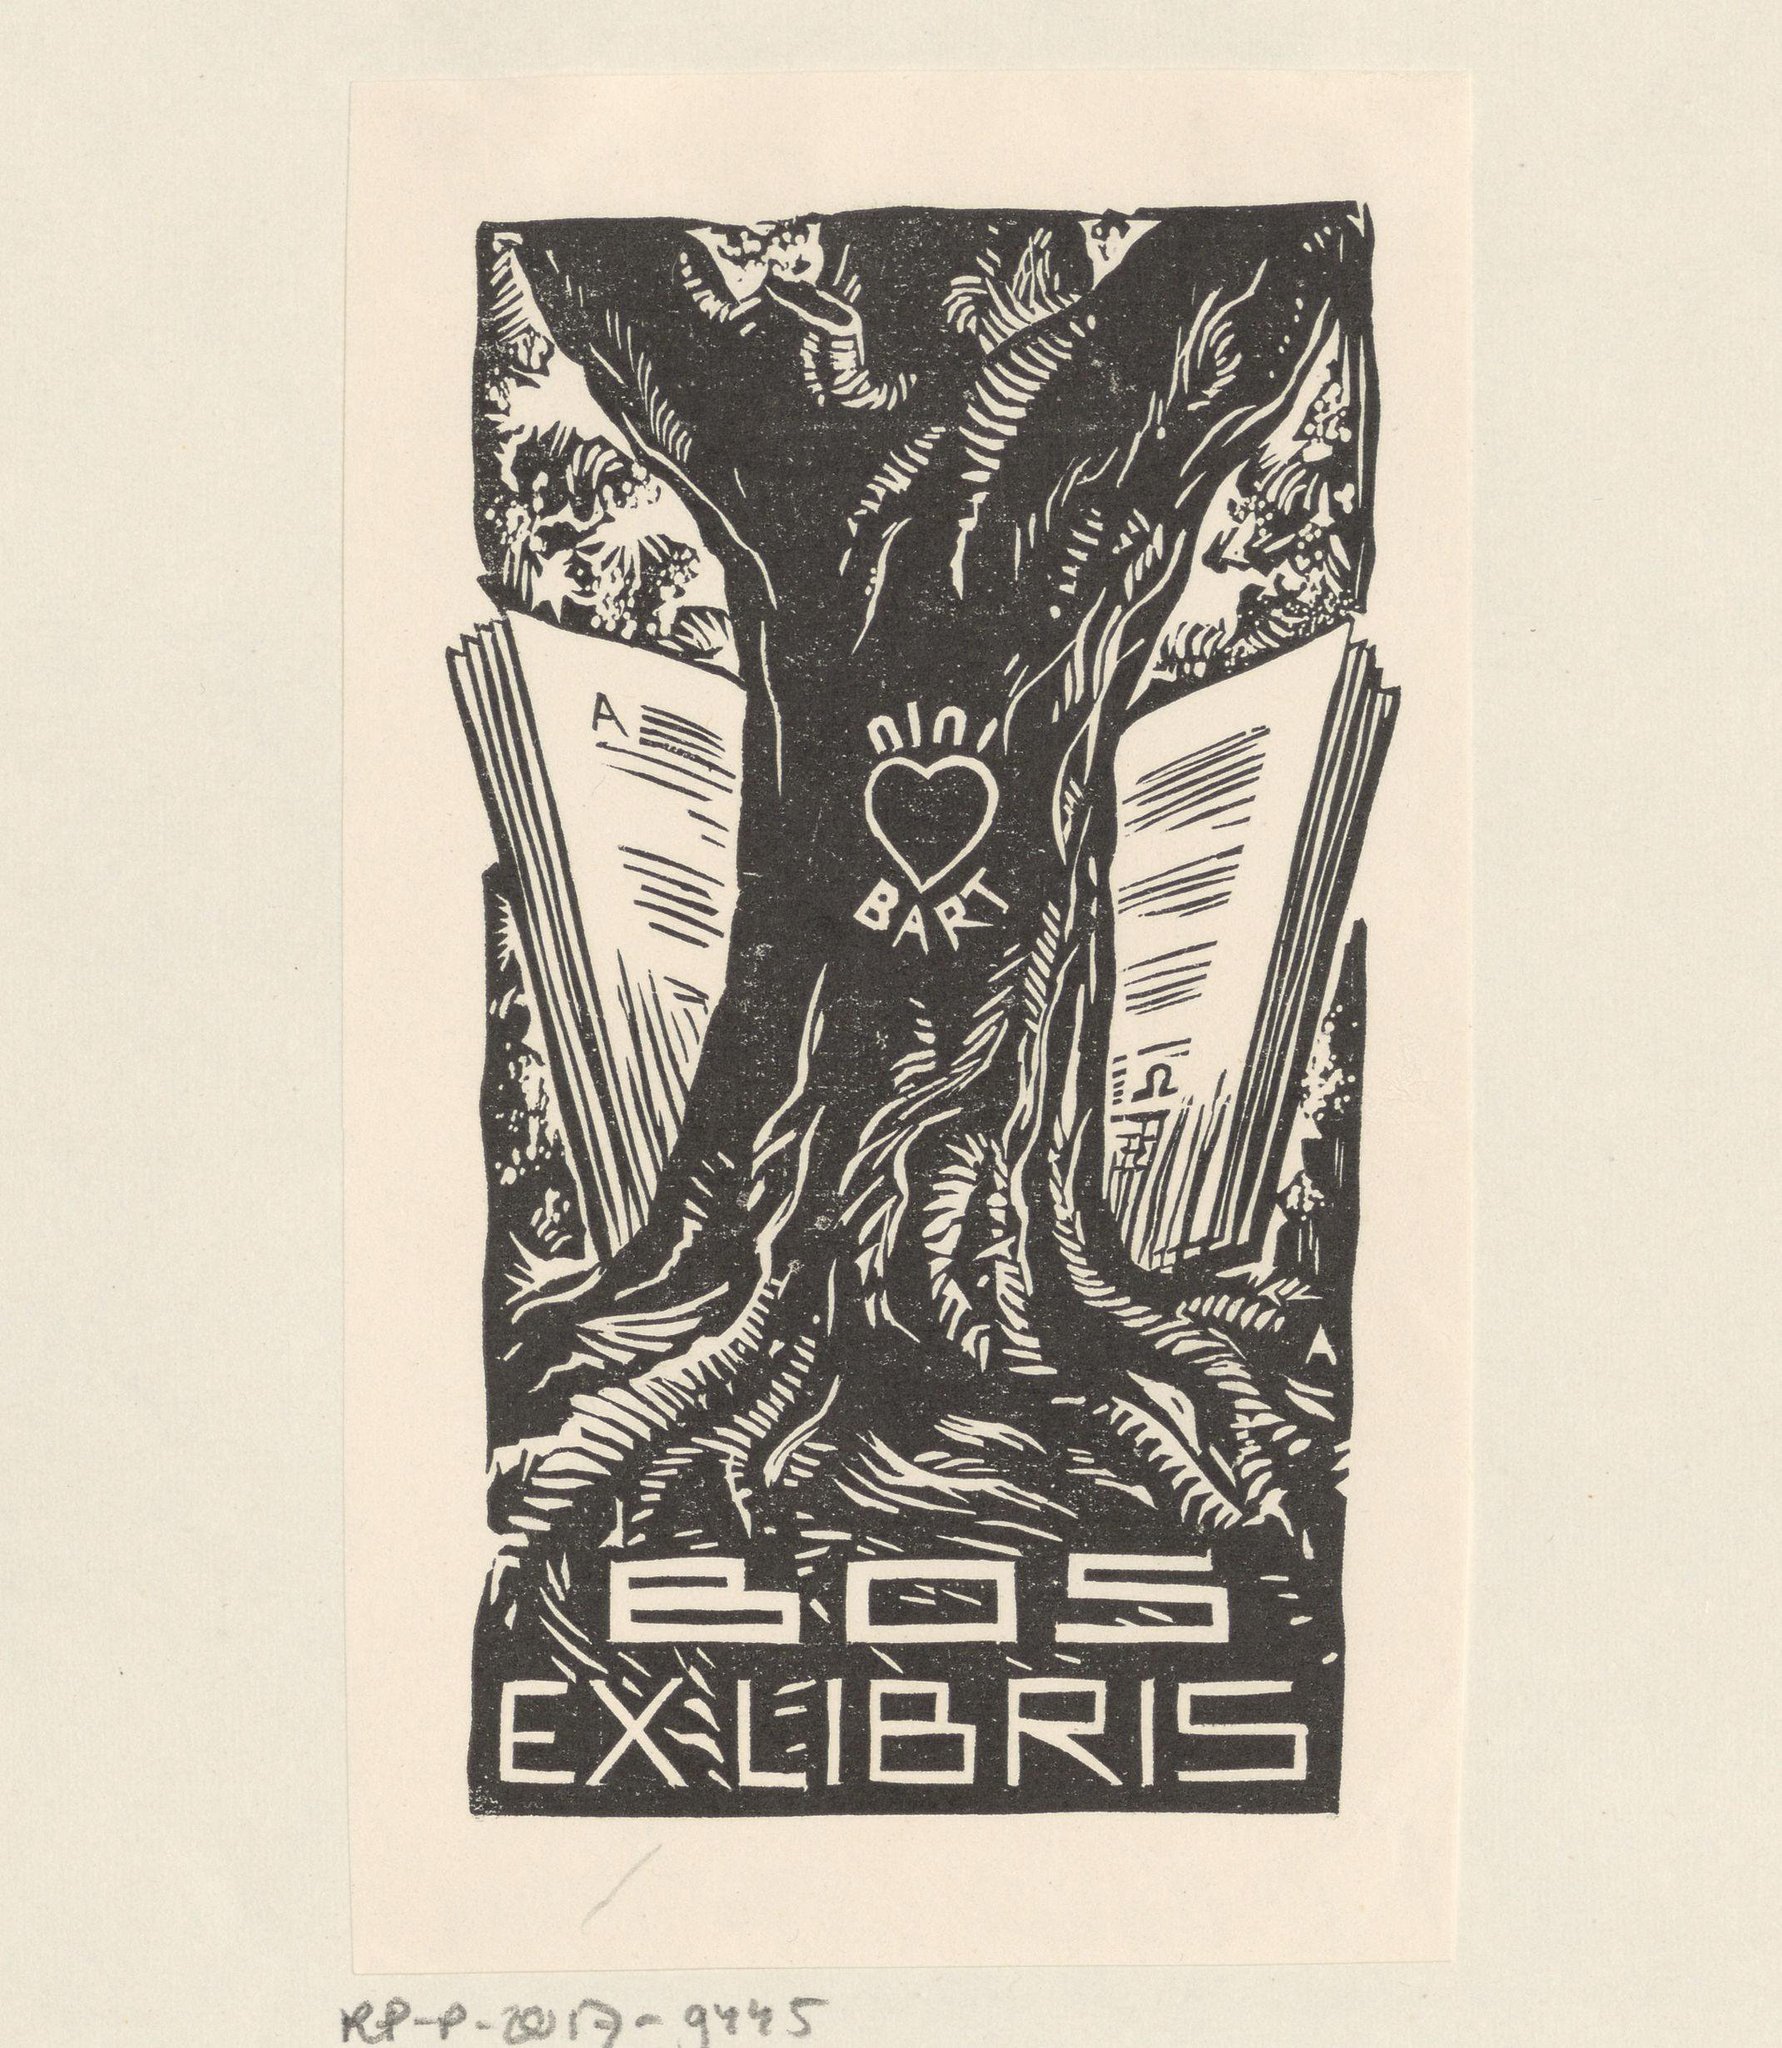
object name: bookplate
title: Ex libris van Nini en Bart Bos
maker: françois d aquin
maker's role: print maker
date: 1950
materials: paper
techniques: woodcut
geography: france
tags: bart bos, book, plants and herbs, alpha and omega ~ symbol of god the father